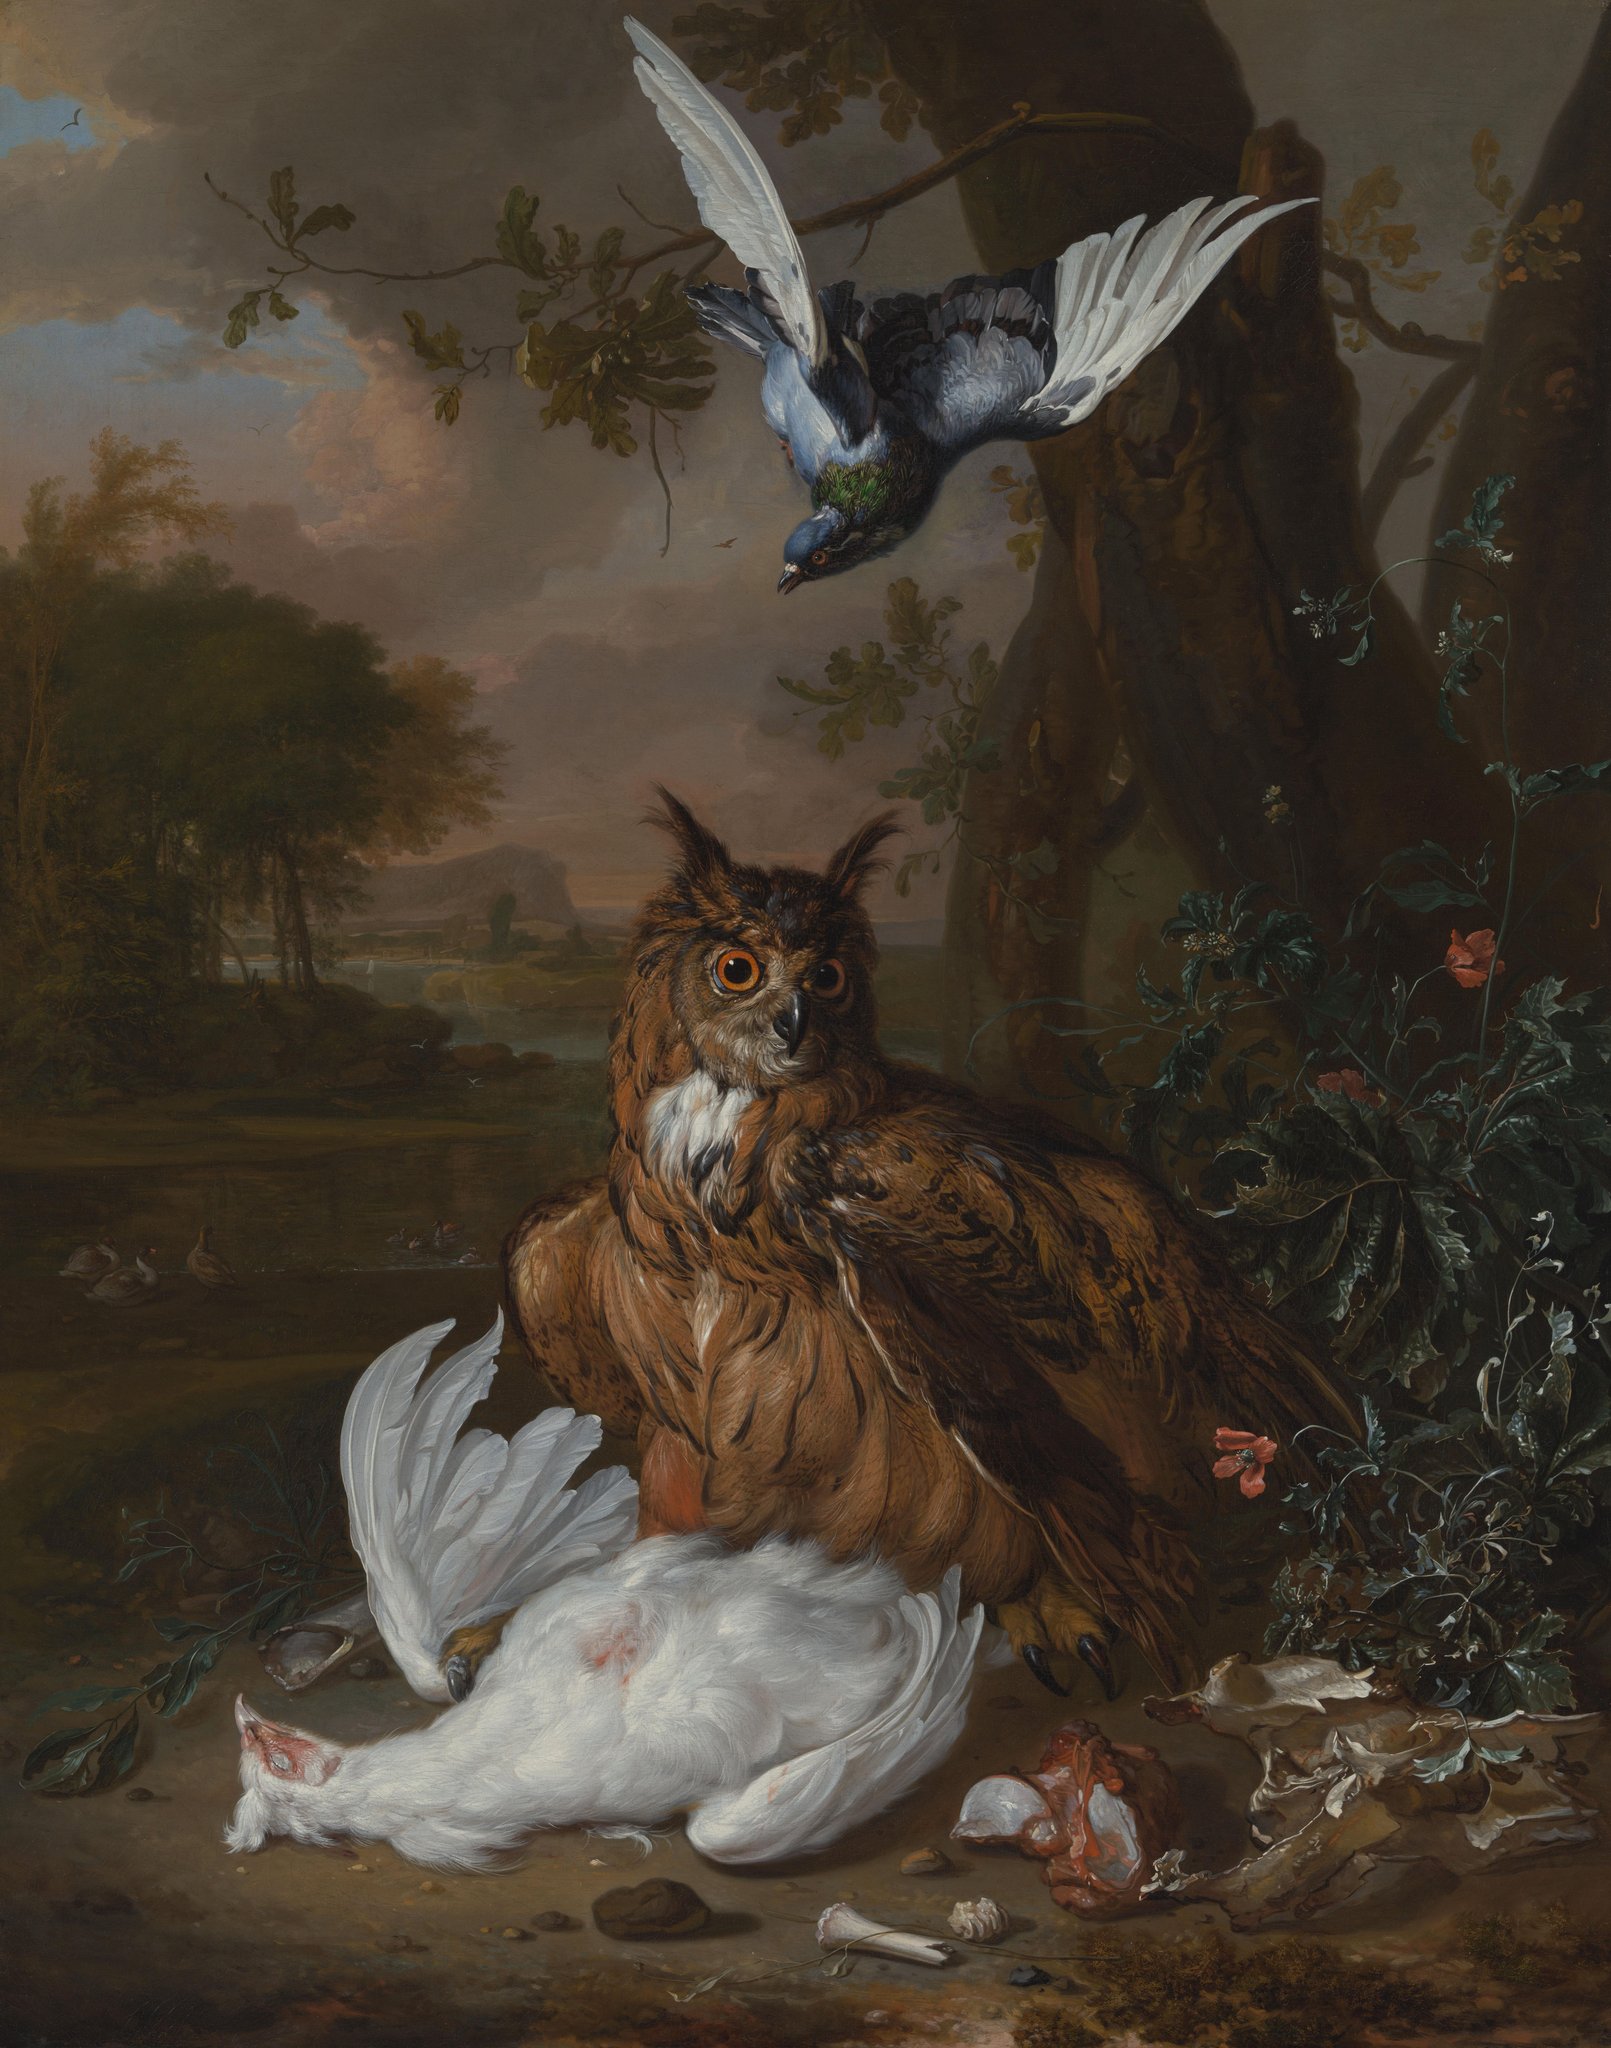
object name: painting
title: A Eurasian eagle-owl with other birds in a landscape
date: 1690-1700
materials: canvas, oil, paint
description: Even though owls are night predators, this eagle-owl has managed to catch a chicken during the day. It looks up angrily from his prey while being harassed by a wood pigeon. In general, in daytime, other birds ill try to keep owls from sleeping and chase them away. Eagle-owls are rarely found in the Netherlands. Dirk Valkenburg also worked in Vienna, which is where he most likely portrayed this imposing creature.